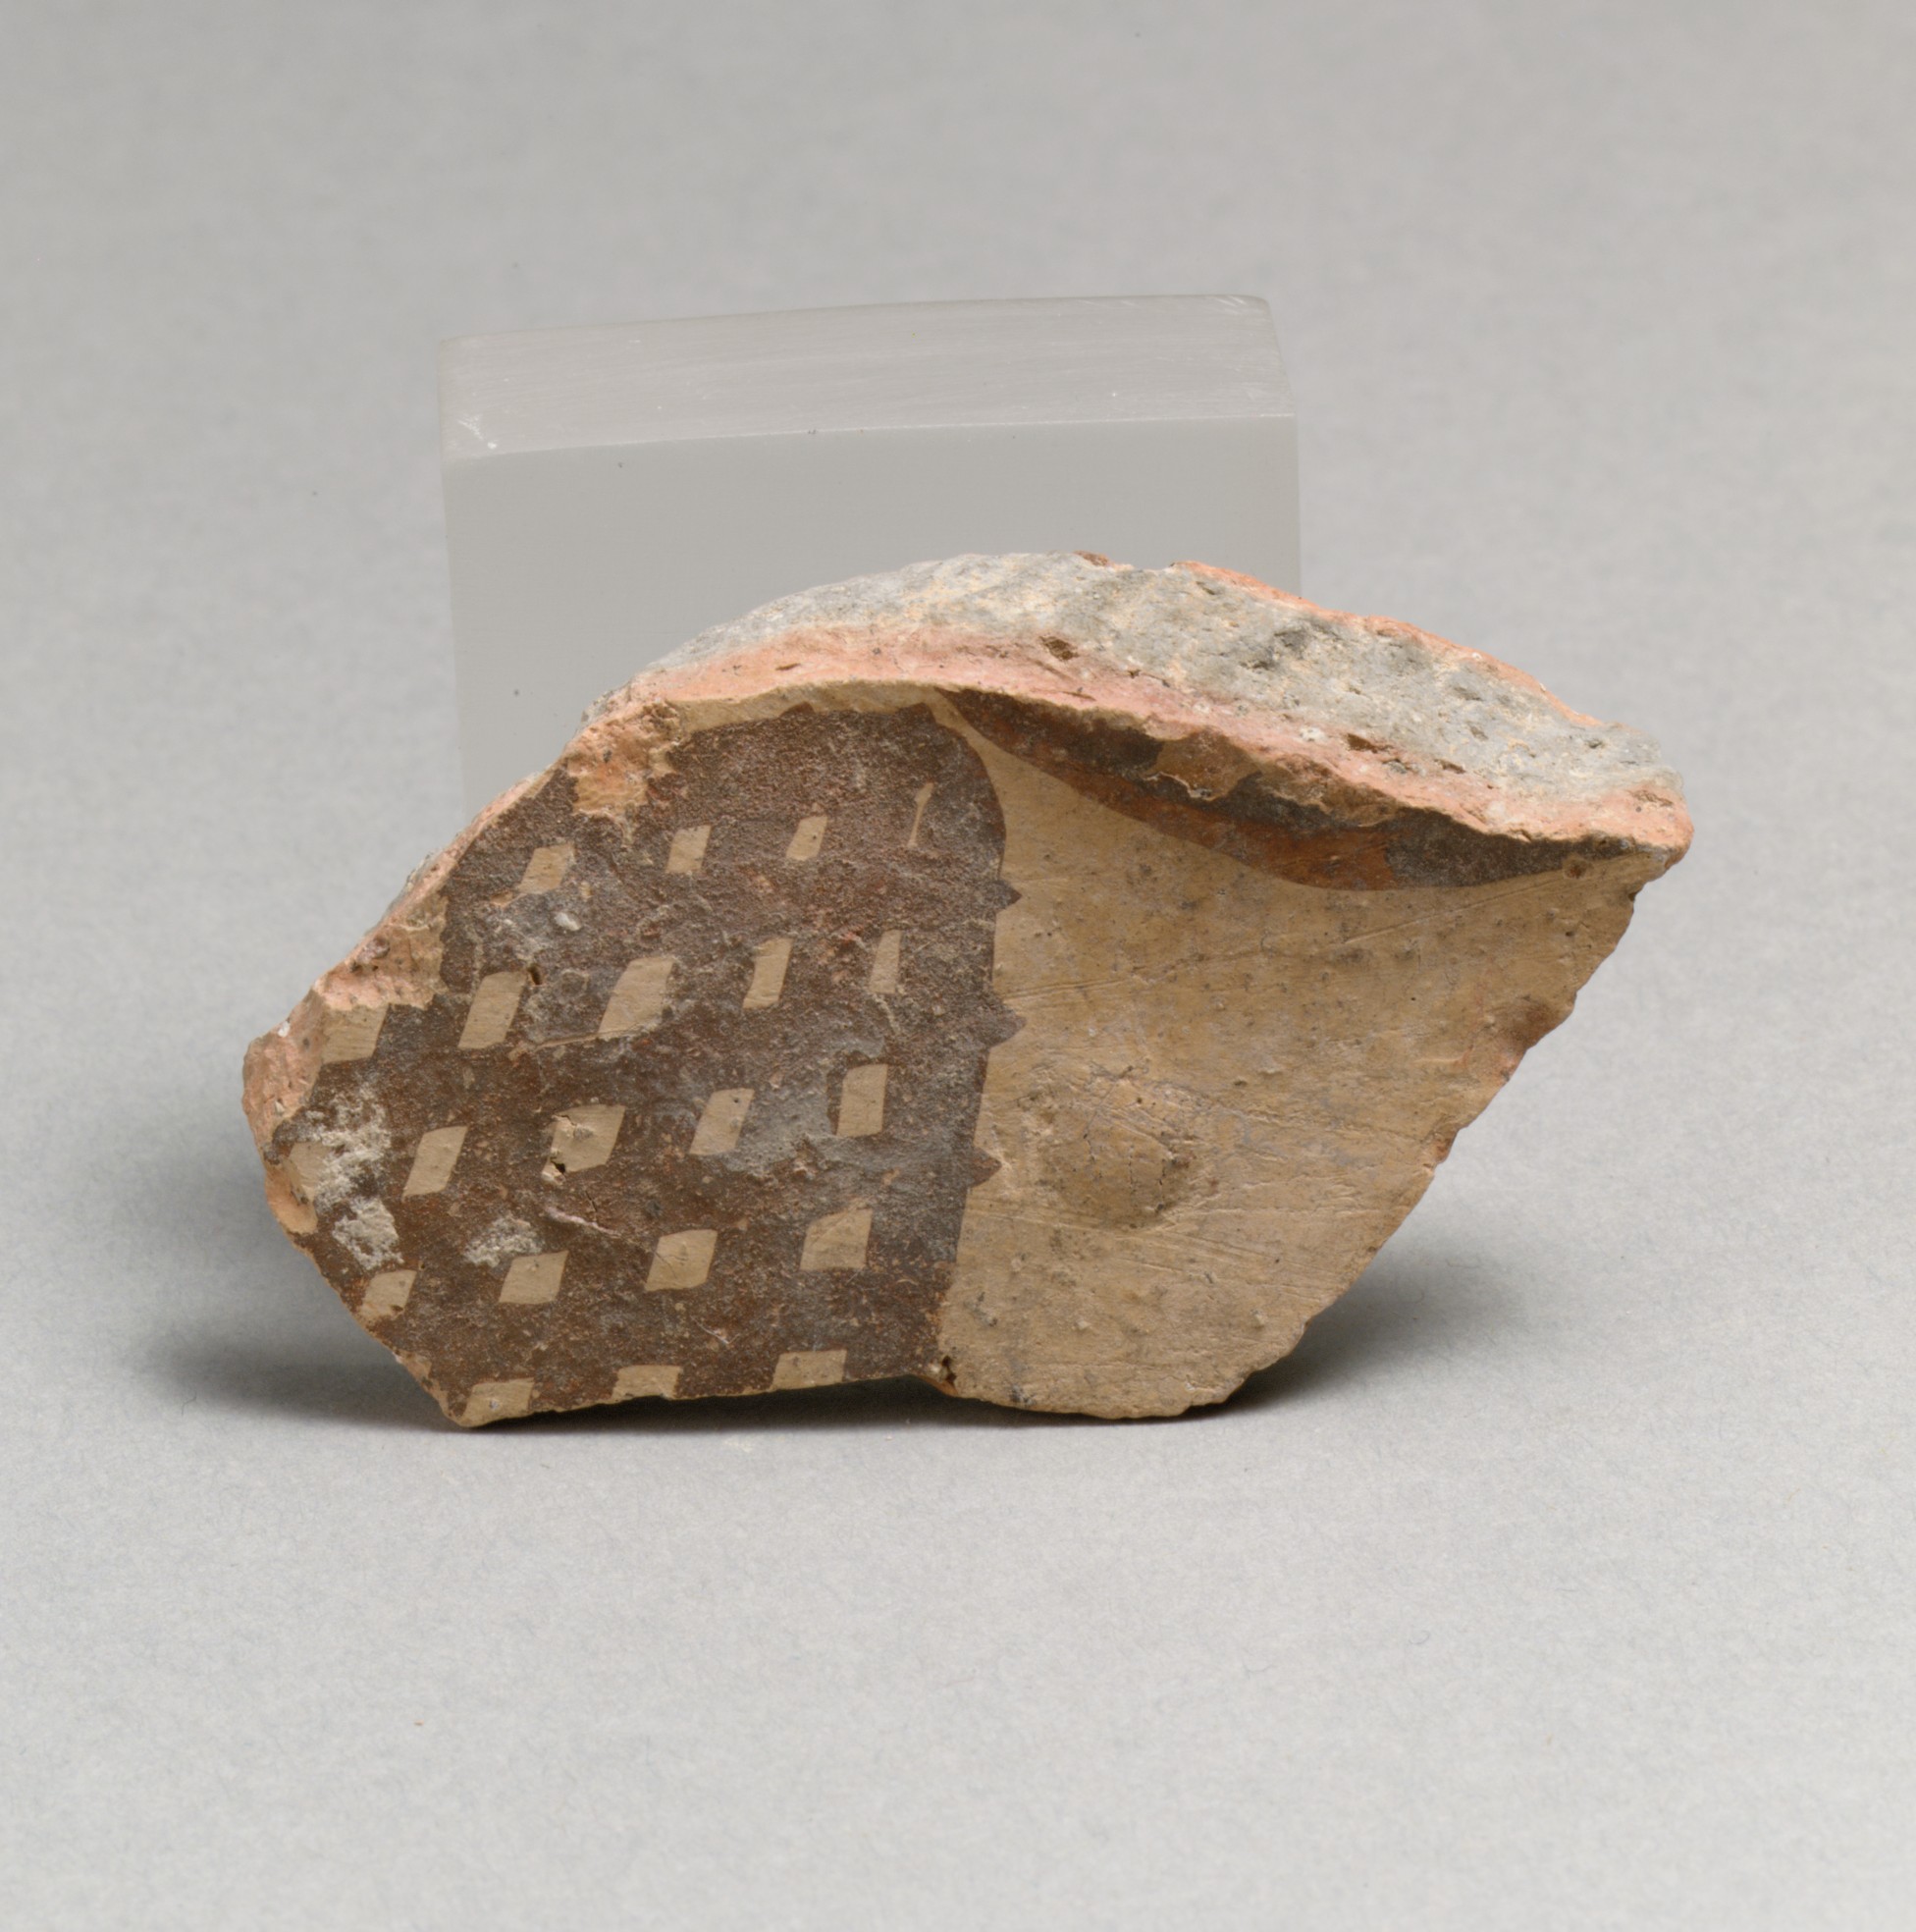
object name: vase fragment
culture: minoan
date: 2600-2000 BCE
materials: terracotta